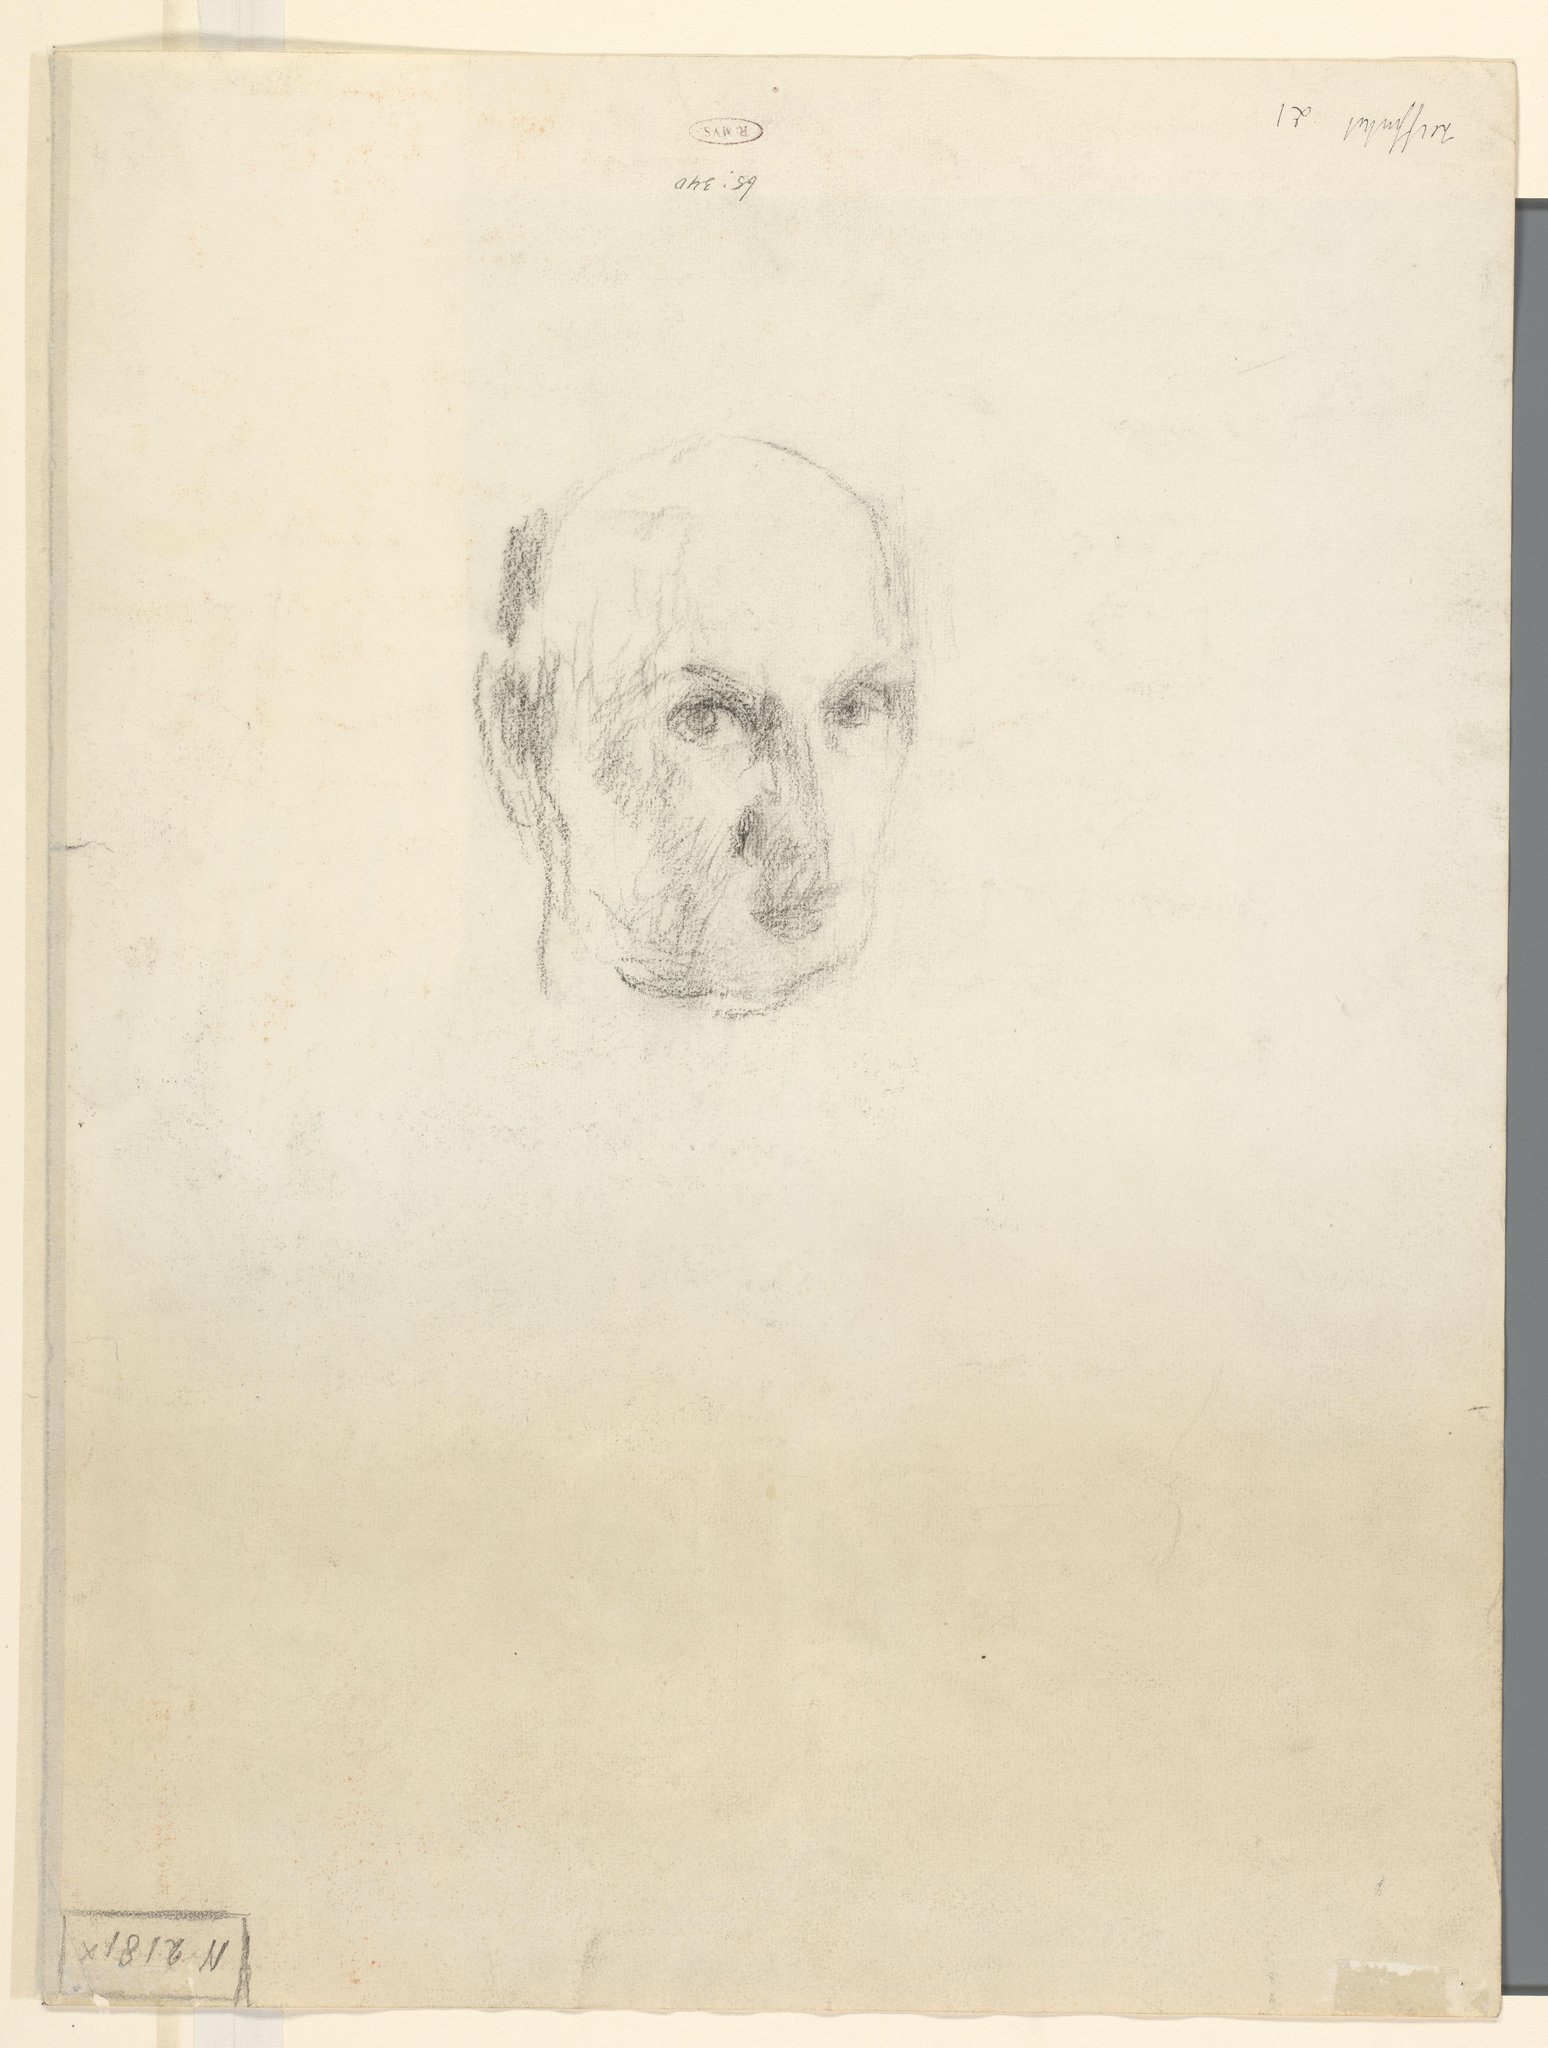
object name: drawing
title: Onvoltooid zelfportret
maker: marius bauer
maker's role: draughtsman, print maker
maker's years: 1867-1932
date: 1877-1932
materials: chalk, paper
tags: amsterdam, print maker, draughtsman, marius bauer, historical persons, portrait, self-portrait of painter, portrait, self-portrait of artist, portrait, self-portrait of graphic artist, portrait, self-portrait of draughtsman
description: Onvoltooid zelfportret van de schilder, tekenaar en etser Marius Bauer.